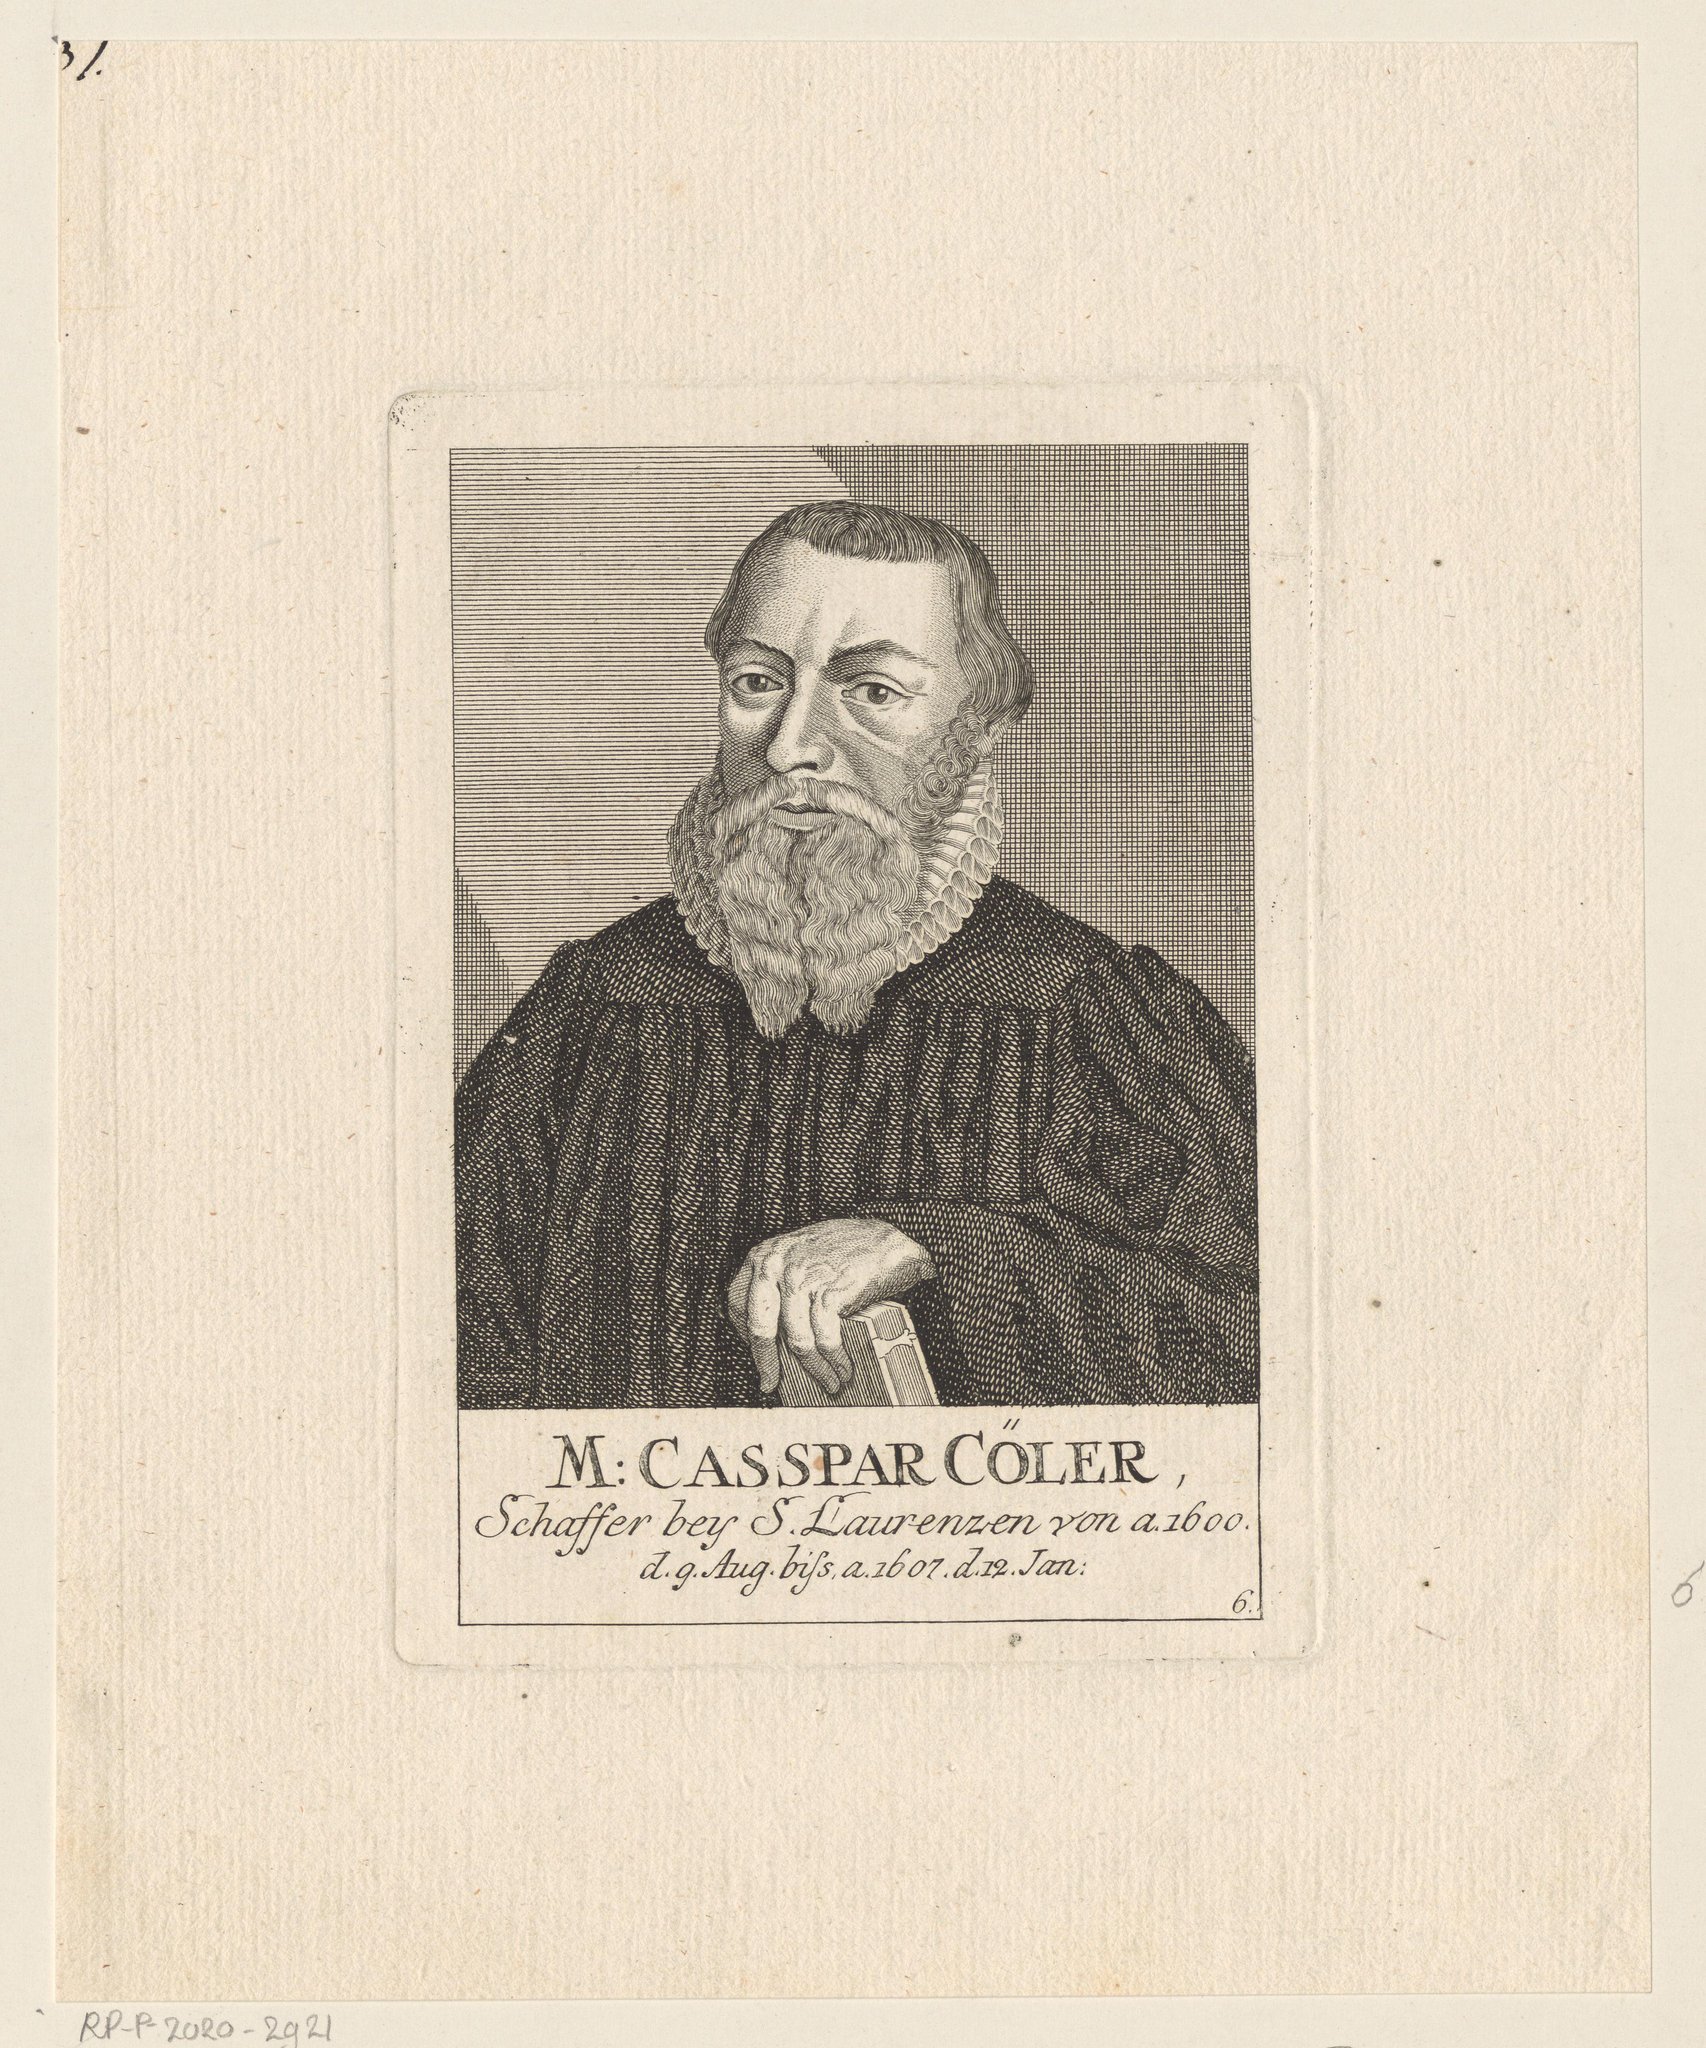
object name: print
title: Portret van Caspar Cöler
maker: Anonymous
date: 1756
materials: paper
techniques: engraving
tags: theologian, historical persons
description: Prent mogelijk uit: Würfel, Andreas. Diptycha ecclesiae Sebaldianae (...). Neurenberg: Christoph Melchior Roth, 1756.